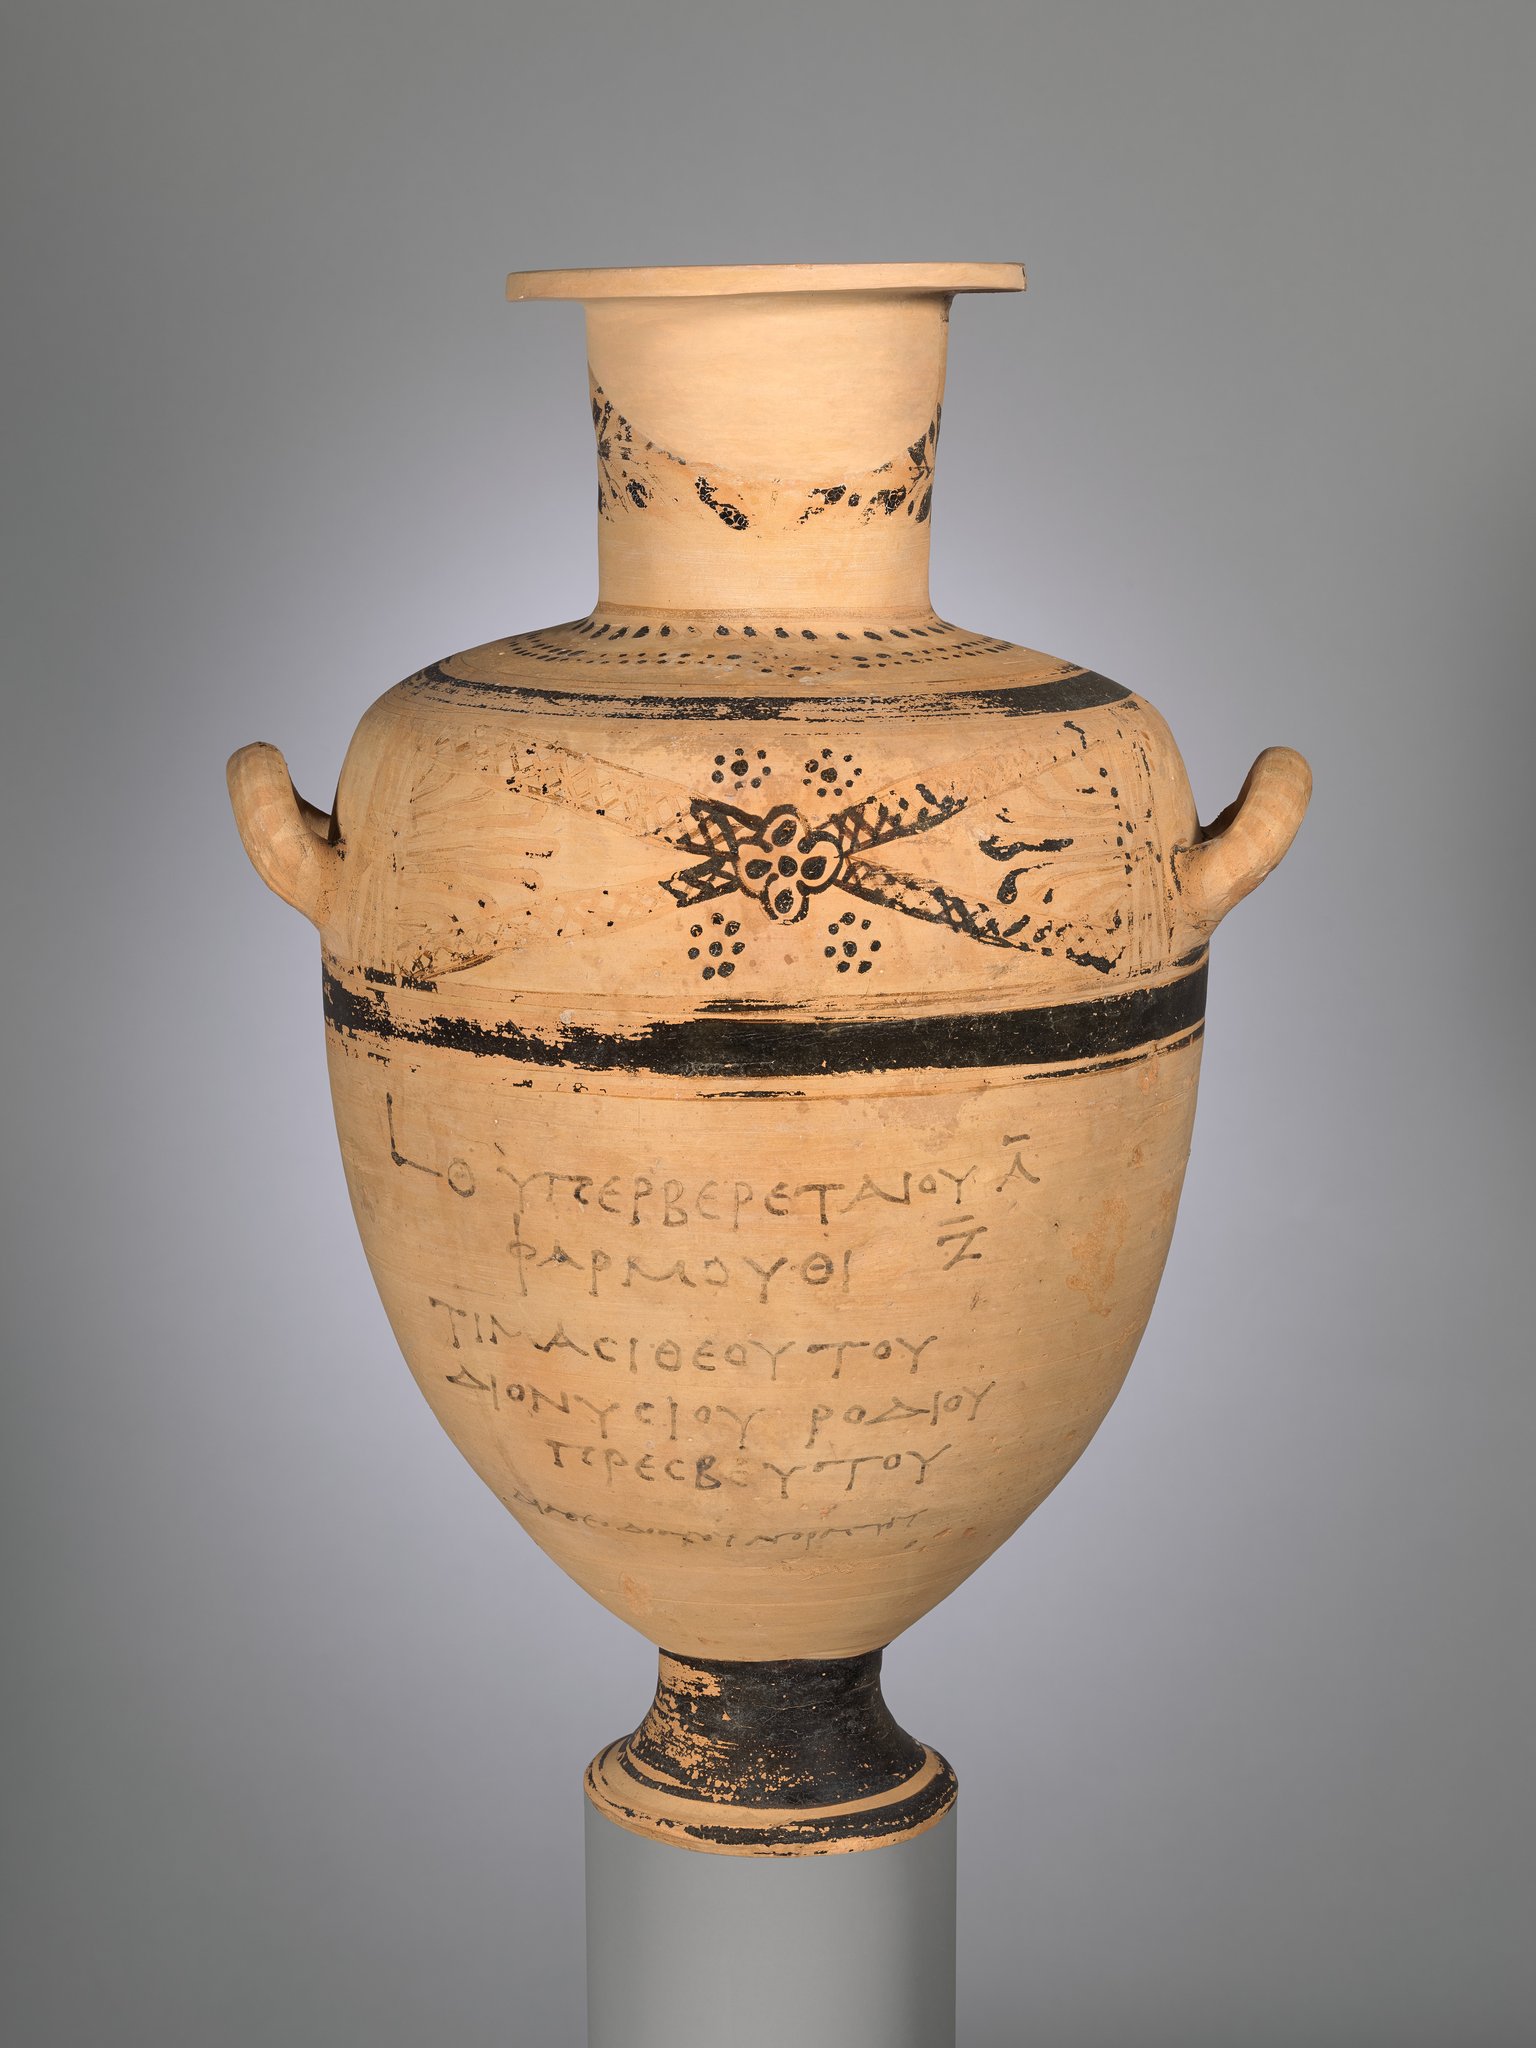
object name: hydria, hadra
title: Terracotta Hadra hydria (water jar)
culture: greek, cretan or ptolemaic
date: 213 BCE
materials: terracotta